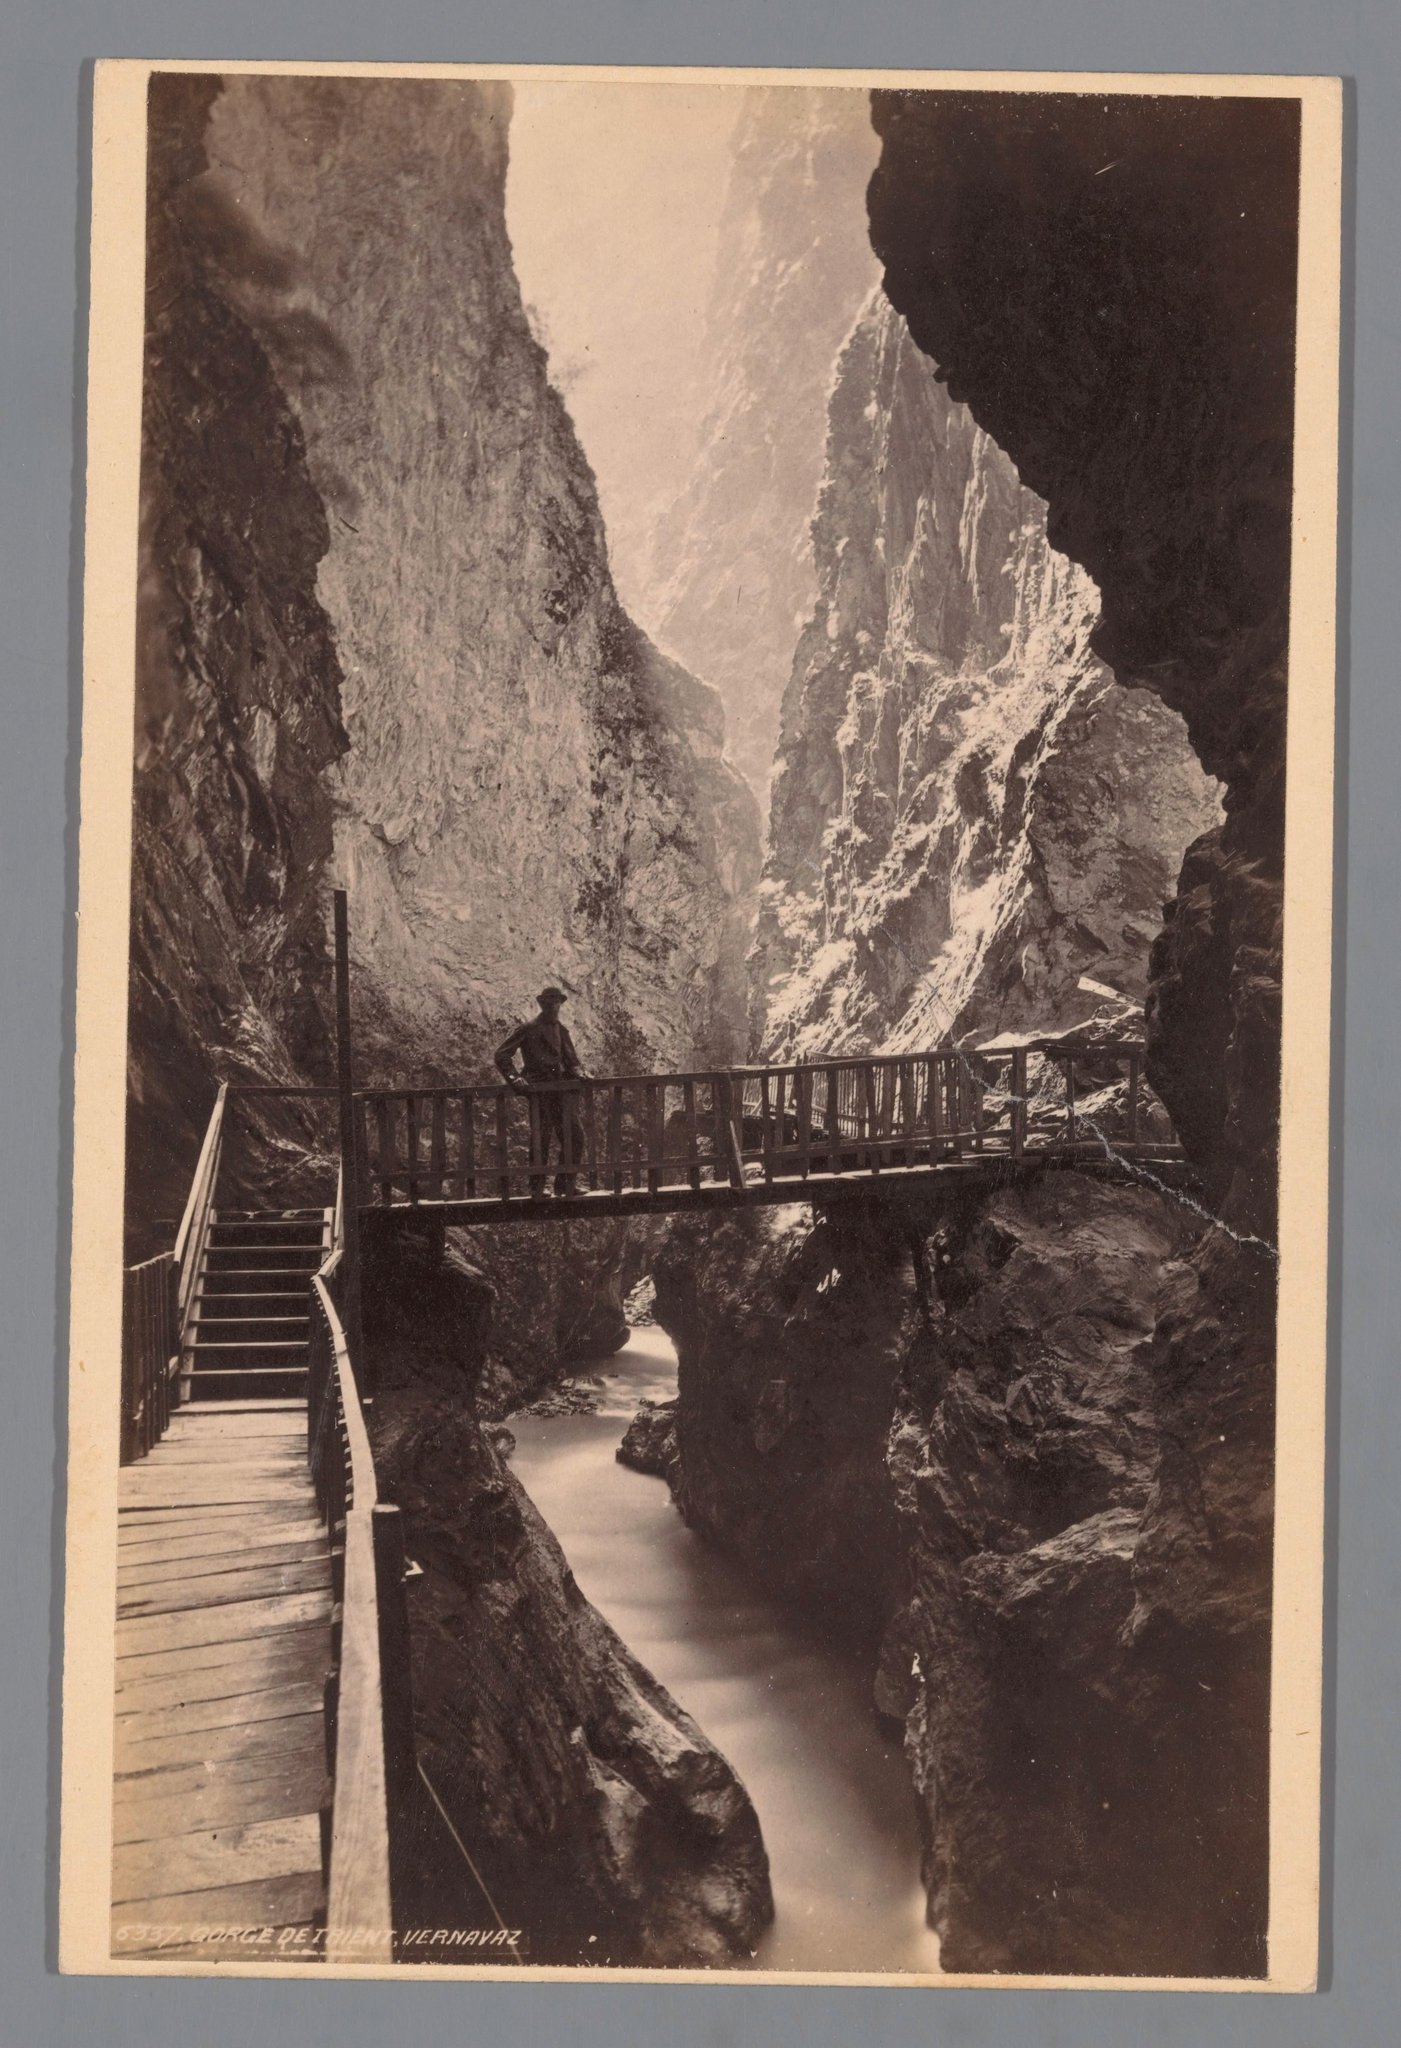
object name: cabinet photograph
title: Gorge de Trient, Vernavaz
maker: francis frith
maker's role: publisher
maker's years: 1822-1898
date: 1880-1920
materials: cardboard, photographic support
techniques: albumen print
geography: switzerland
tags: dale, valley, switzerland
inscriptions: number: ‘6337’, name: ‘Frith's Cabinet Series Switzerland’